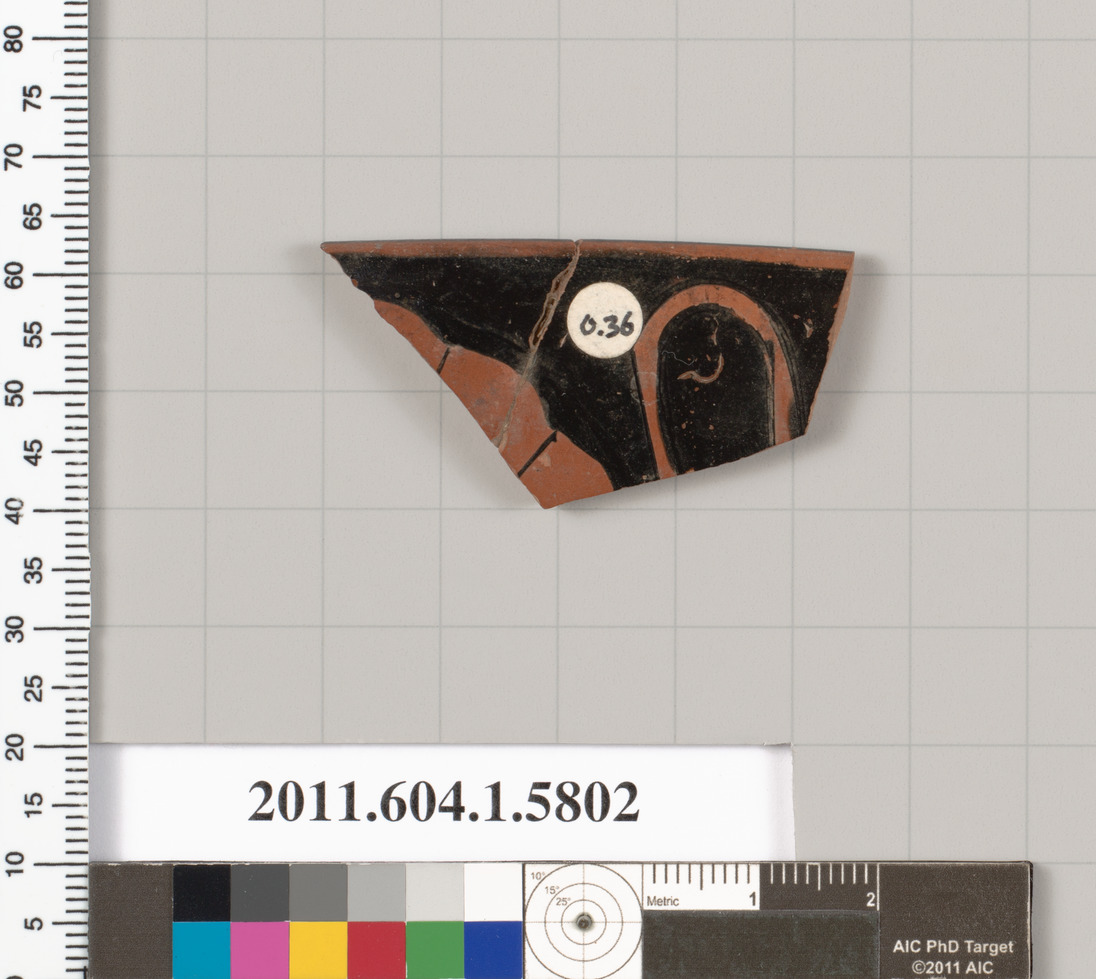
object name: kylix fragment, eye cup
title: Terracotta rim fragment of a kylix: eye-cup (drinking cup)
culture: greek, attic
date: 520-510 BCE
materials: terracotta